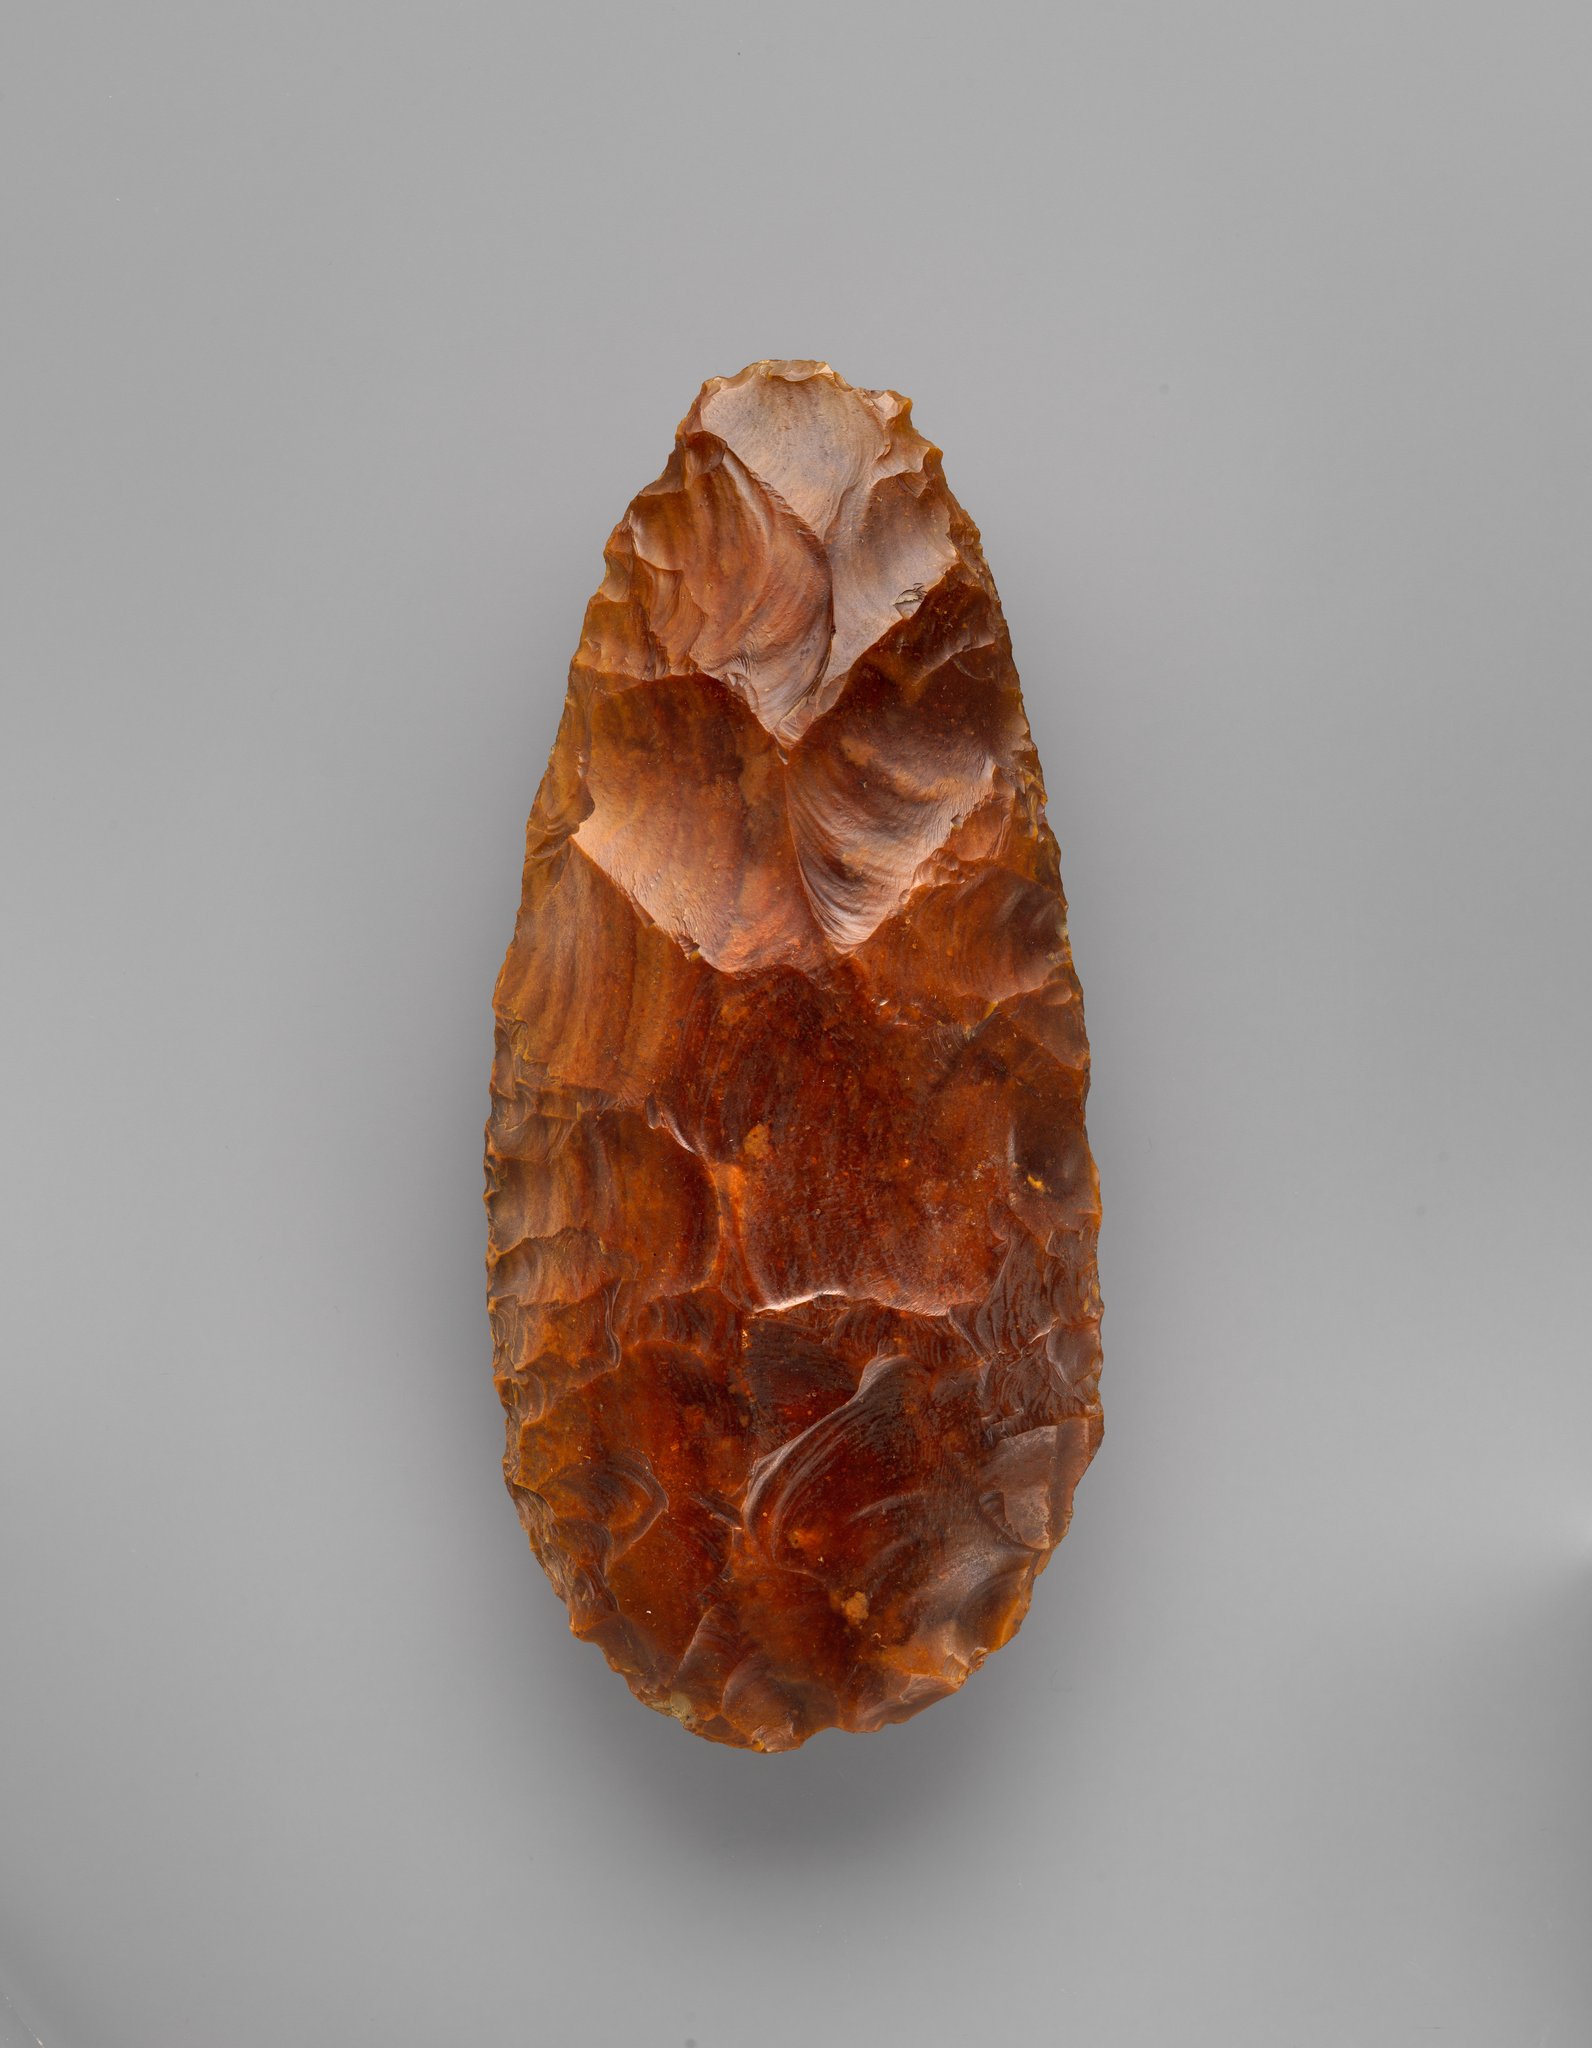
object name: biface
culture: acheulean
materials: stone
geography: france